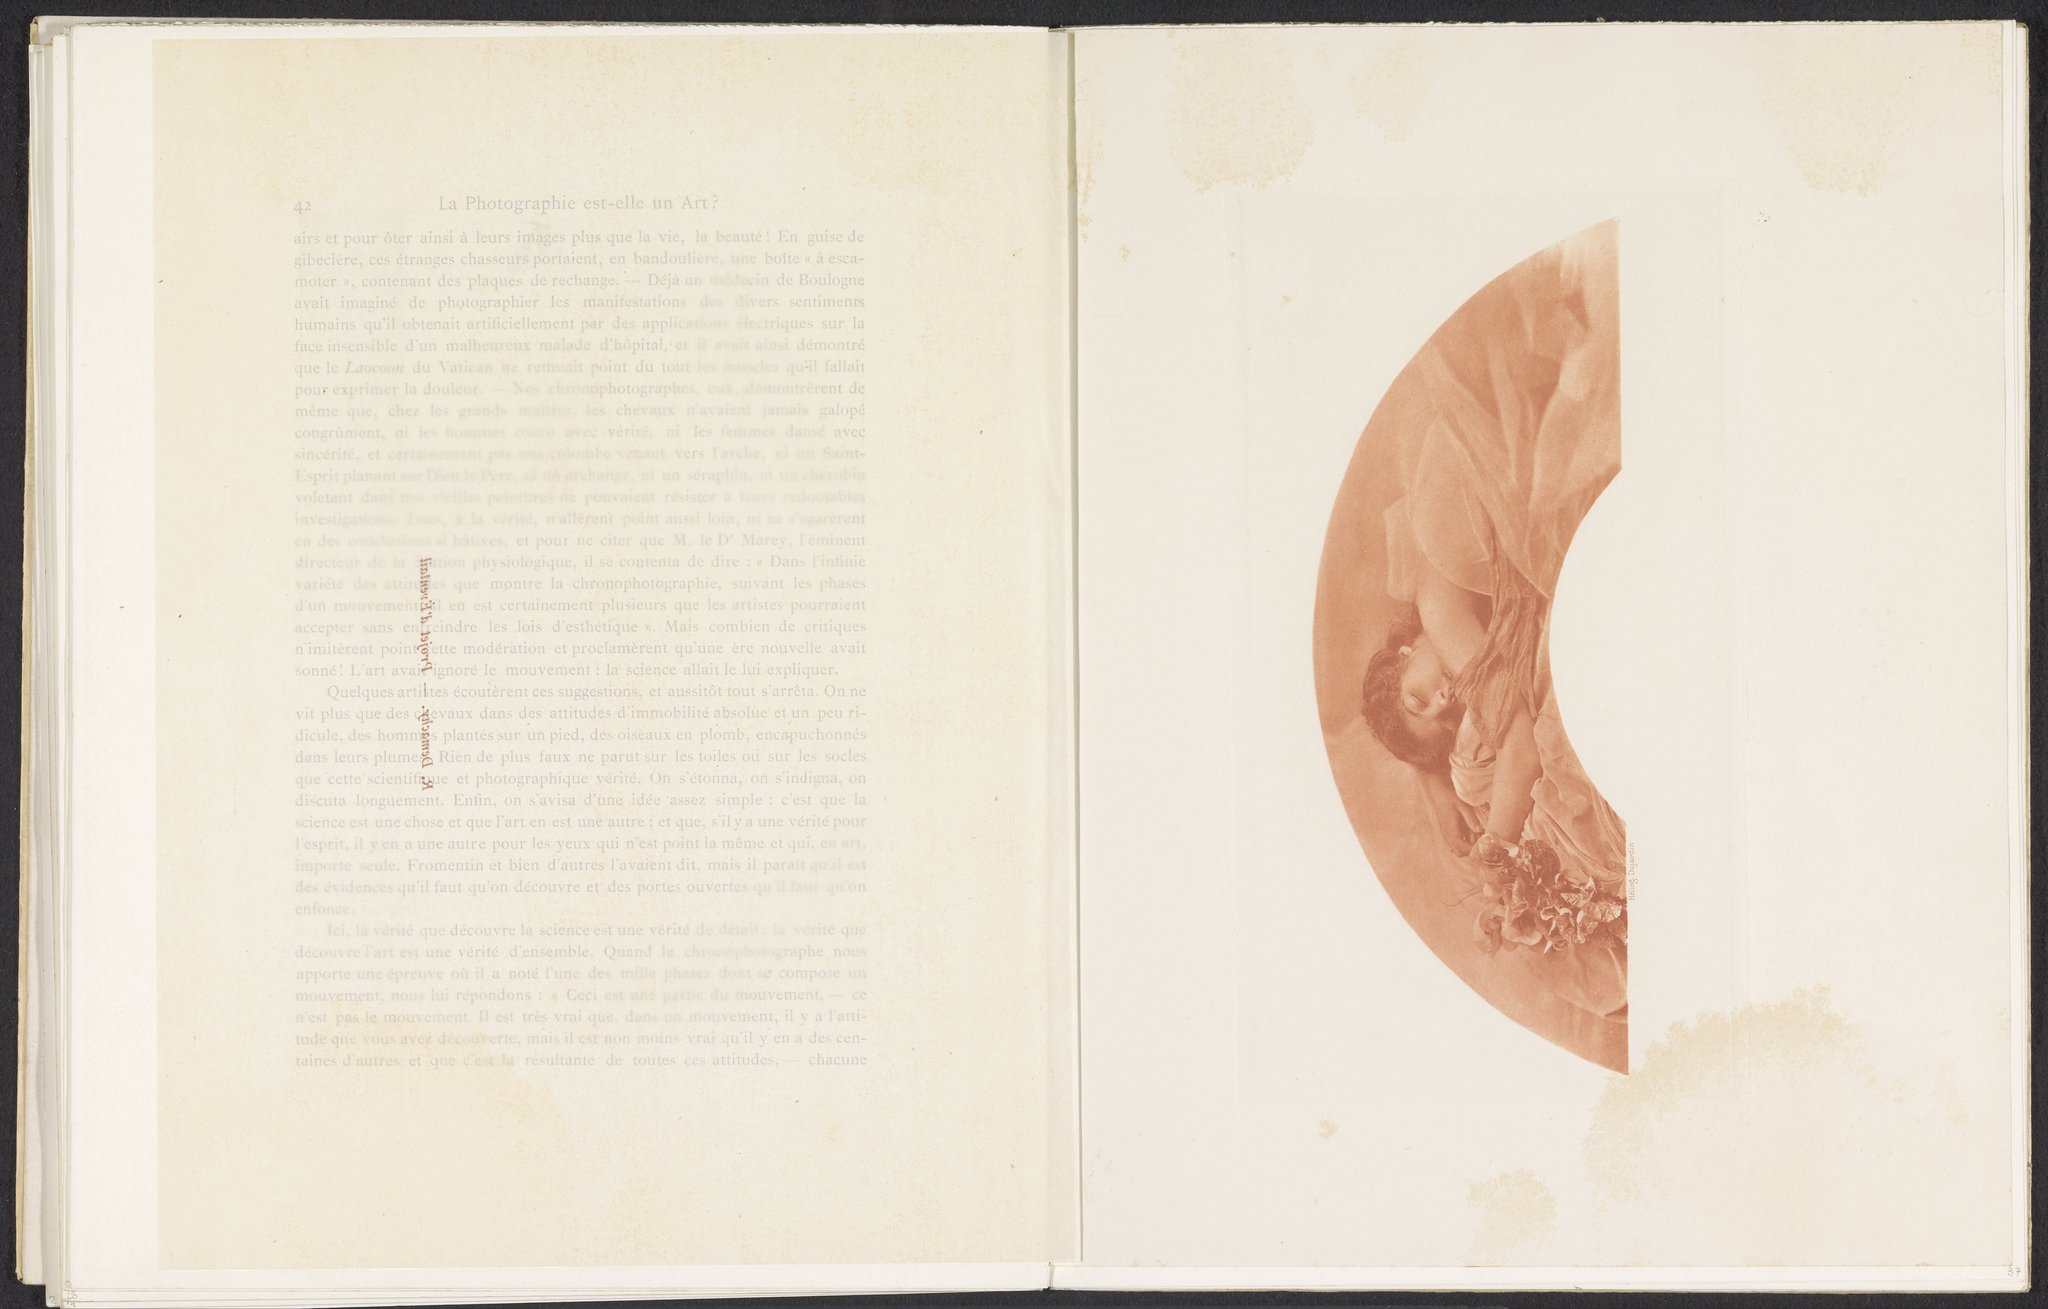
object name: photomechanical print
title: Projet d'Éventail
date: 1889-1899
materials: paper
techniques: photoaquatint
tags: sleeping; unconsciousness